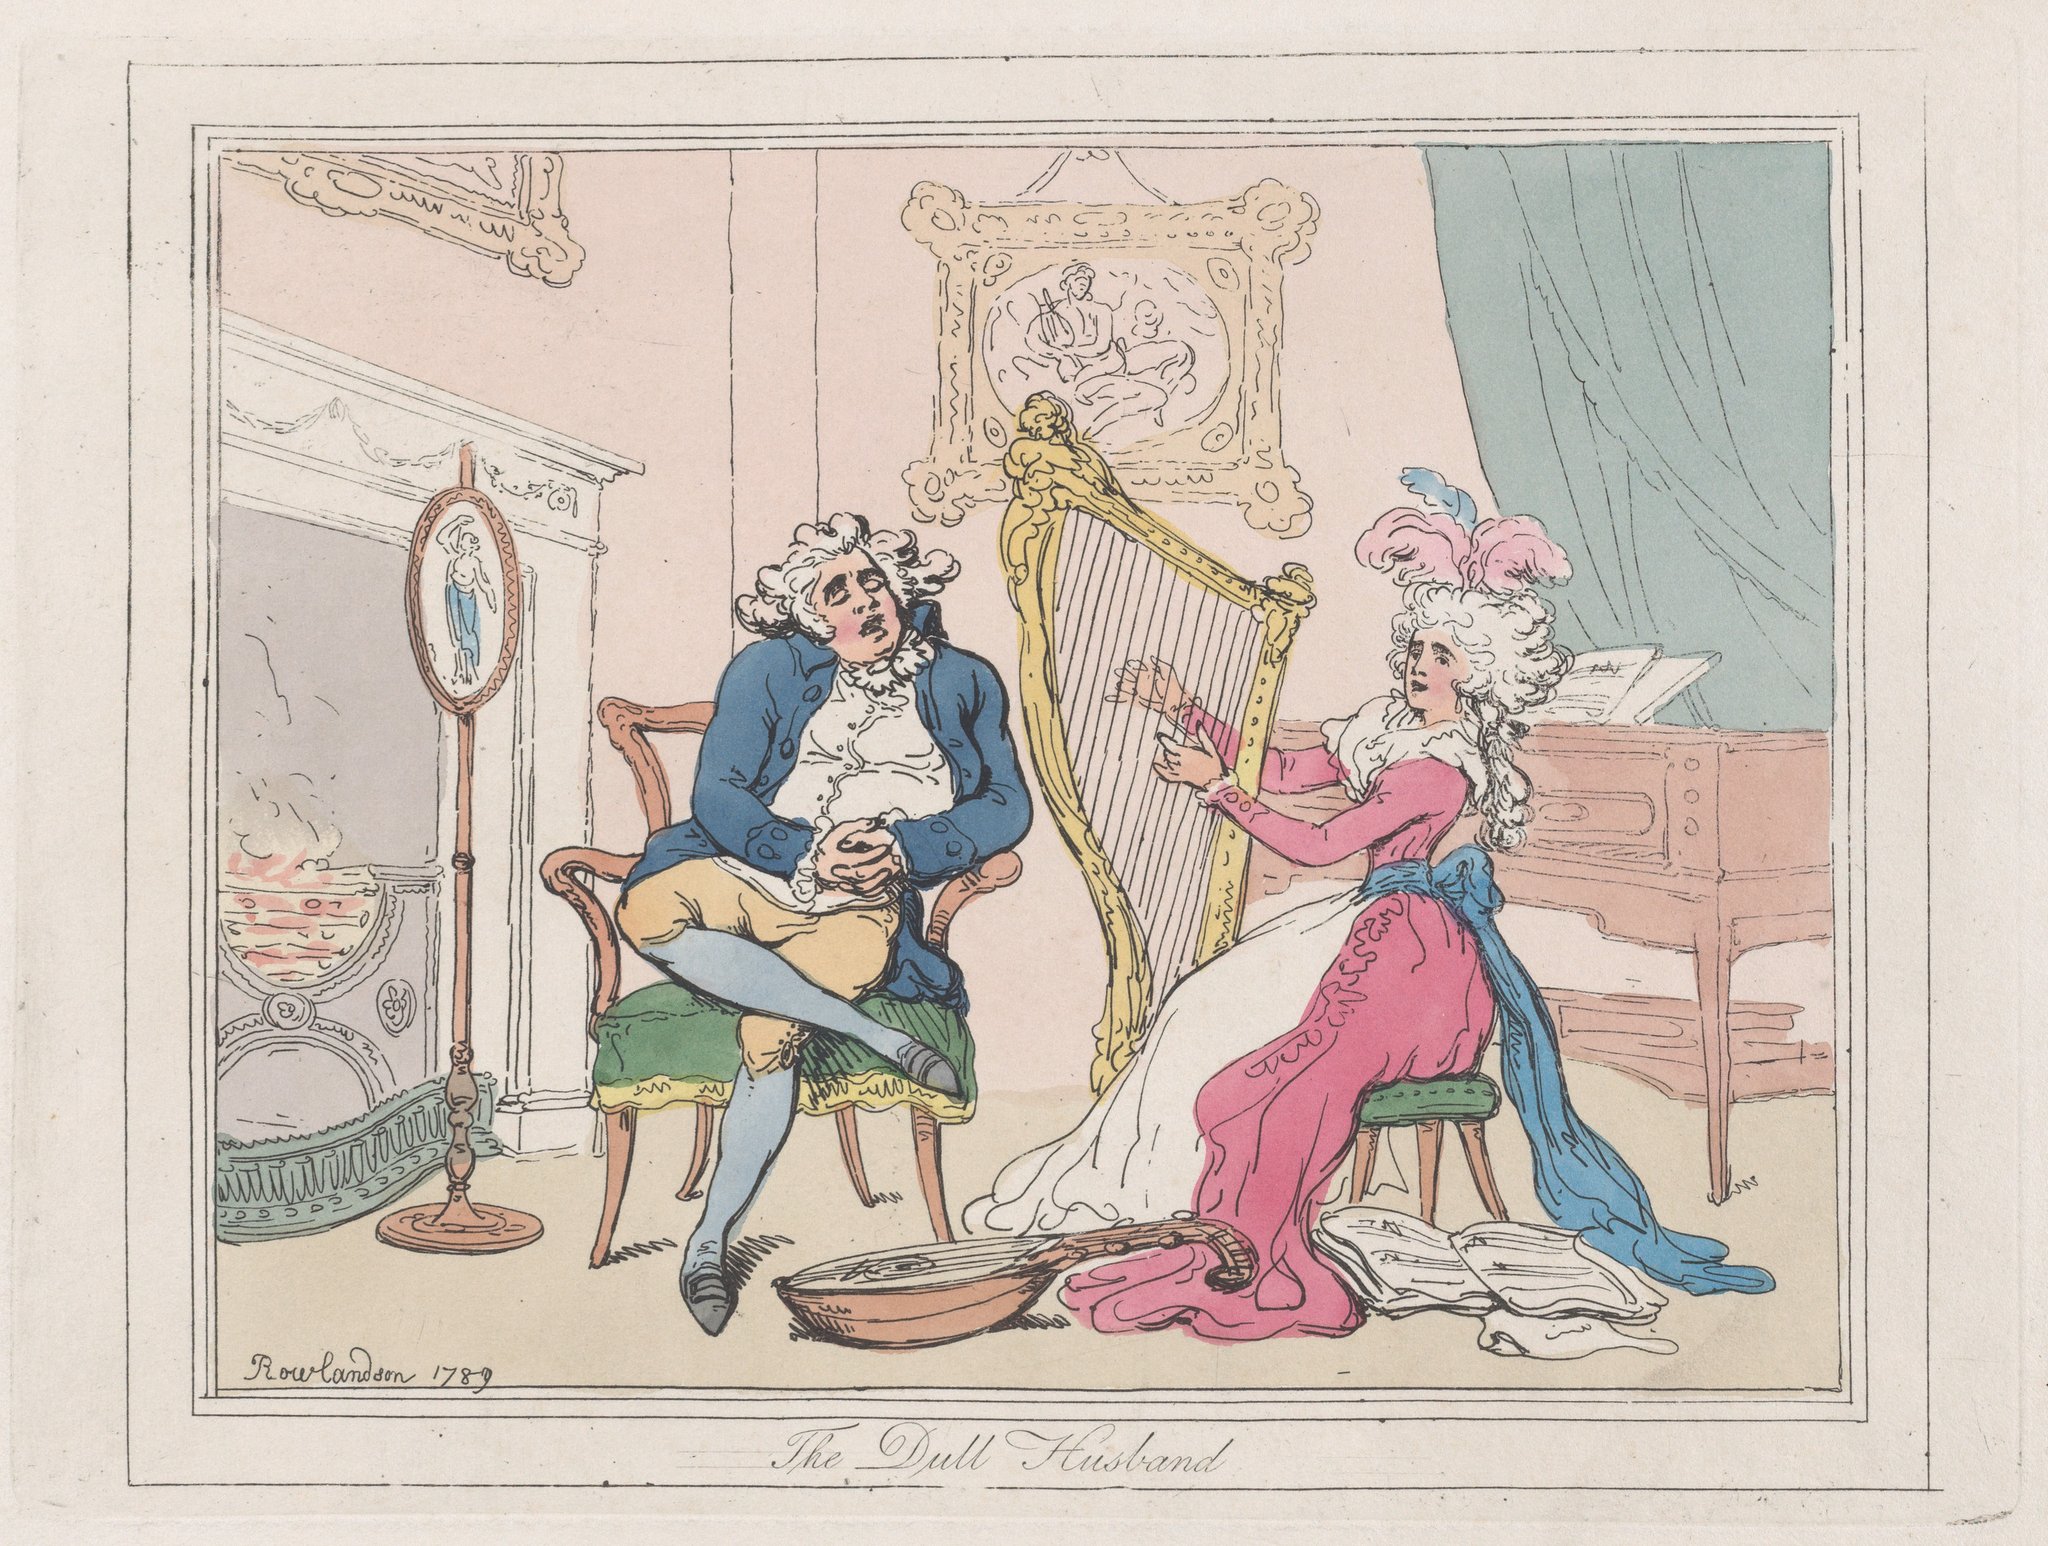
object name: print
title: The Dull Husband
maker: thomas rowlandson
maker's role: artist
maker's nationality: british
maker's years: 1757-1827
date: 1789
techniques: aquatint, etching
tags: satire,men,women,harps